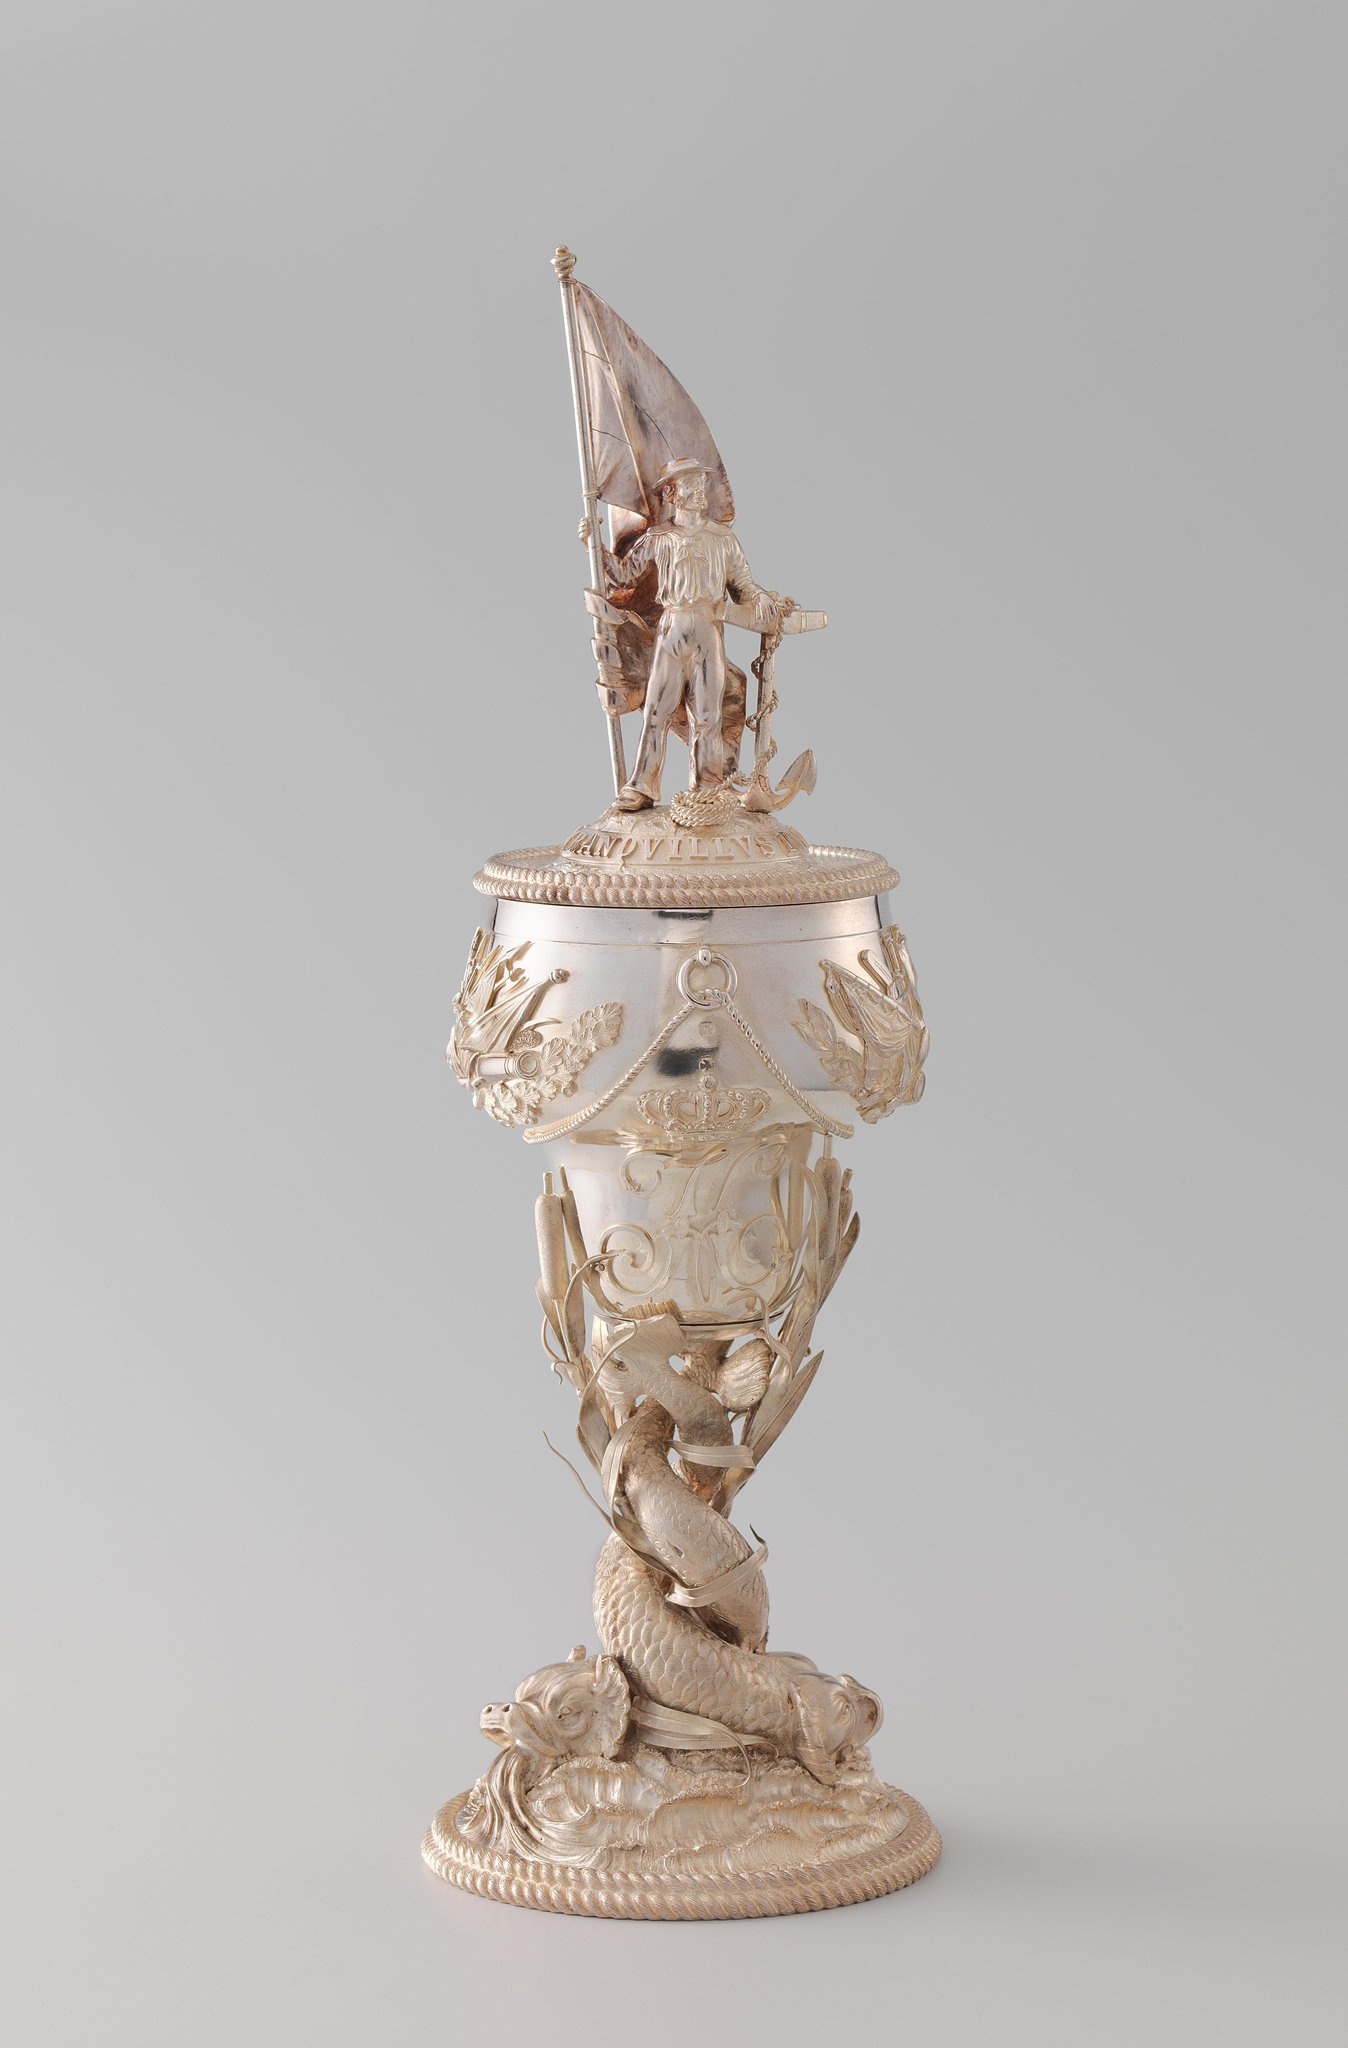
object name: cup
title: Silver Birthday Cup for Lieutenant Admiral Engelbert Lucas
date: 1865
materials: silver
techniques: casting, gilding, riveted, screwed, soldering, striking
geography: voorschoten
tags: the hague, engelbertus lucas, hendrik (prins der nederlanden)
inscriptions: hallmark, maker's mark, inscription, on the back: ‘Aan / DEN LUITENANT- / ADMIRAAL / E. LUCAS / Bij het vieren / van zijnen 80sten geboortedag / en als hulde / voor meer dan 70 jaren getrouwe dienst / door hem aan den Lande bewezen / aangeboden / door Z.K.H. PRINS Hendrik / der Nederlanden / LUITENANT ADMIRAAL / Opperbevelheber der vloot / den 30 mei 1865.’, date letter: ‘F’, inscription, on the lid: ‘SAEVIS TRANQVILLVS IN VNDIS.’, alloy mark, maker's mark, retailer's mark: ‘VAN KEMPEN / HOFLEVERANCIER’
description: Zilveren bokaal, de kelk met aan beide zijden krijgs- en marine-attributen, een gekroonde H en opschrift. De schacht bestaat uit twee verstrengelde waterspuwende fantasievissen en riet, de voet heeft een reliëf als water en de randen omsnoerd door kabels. Op de deksel een staande matroos met vlag en anker, kabels en een riem met opschrift om de randen. Gemerkt met meestertekens van Van Kempen, jaarletter F (=1865), Minervakop en keurmerken.